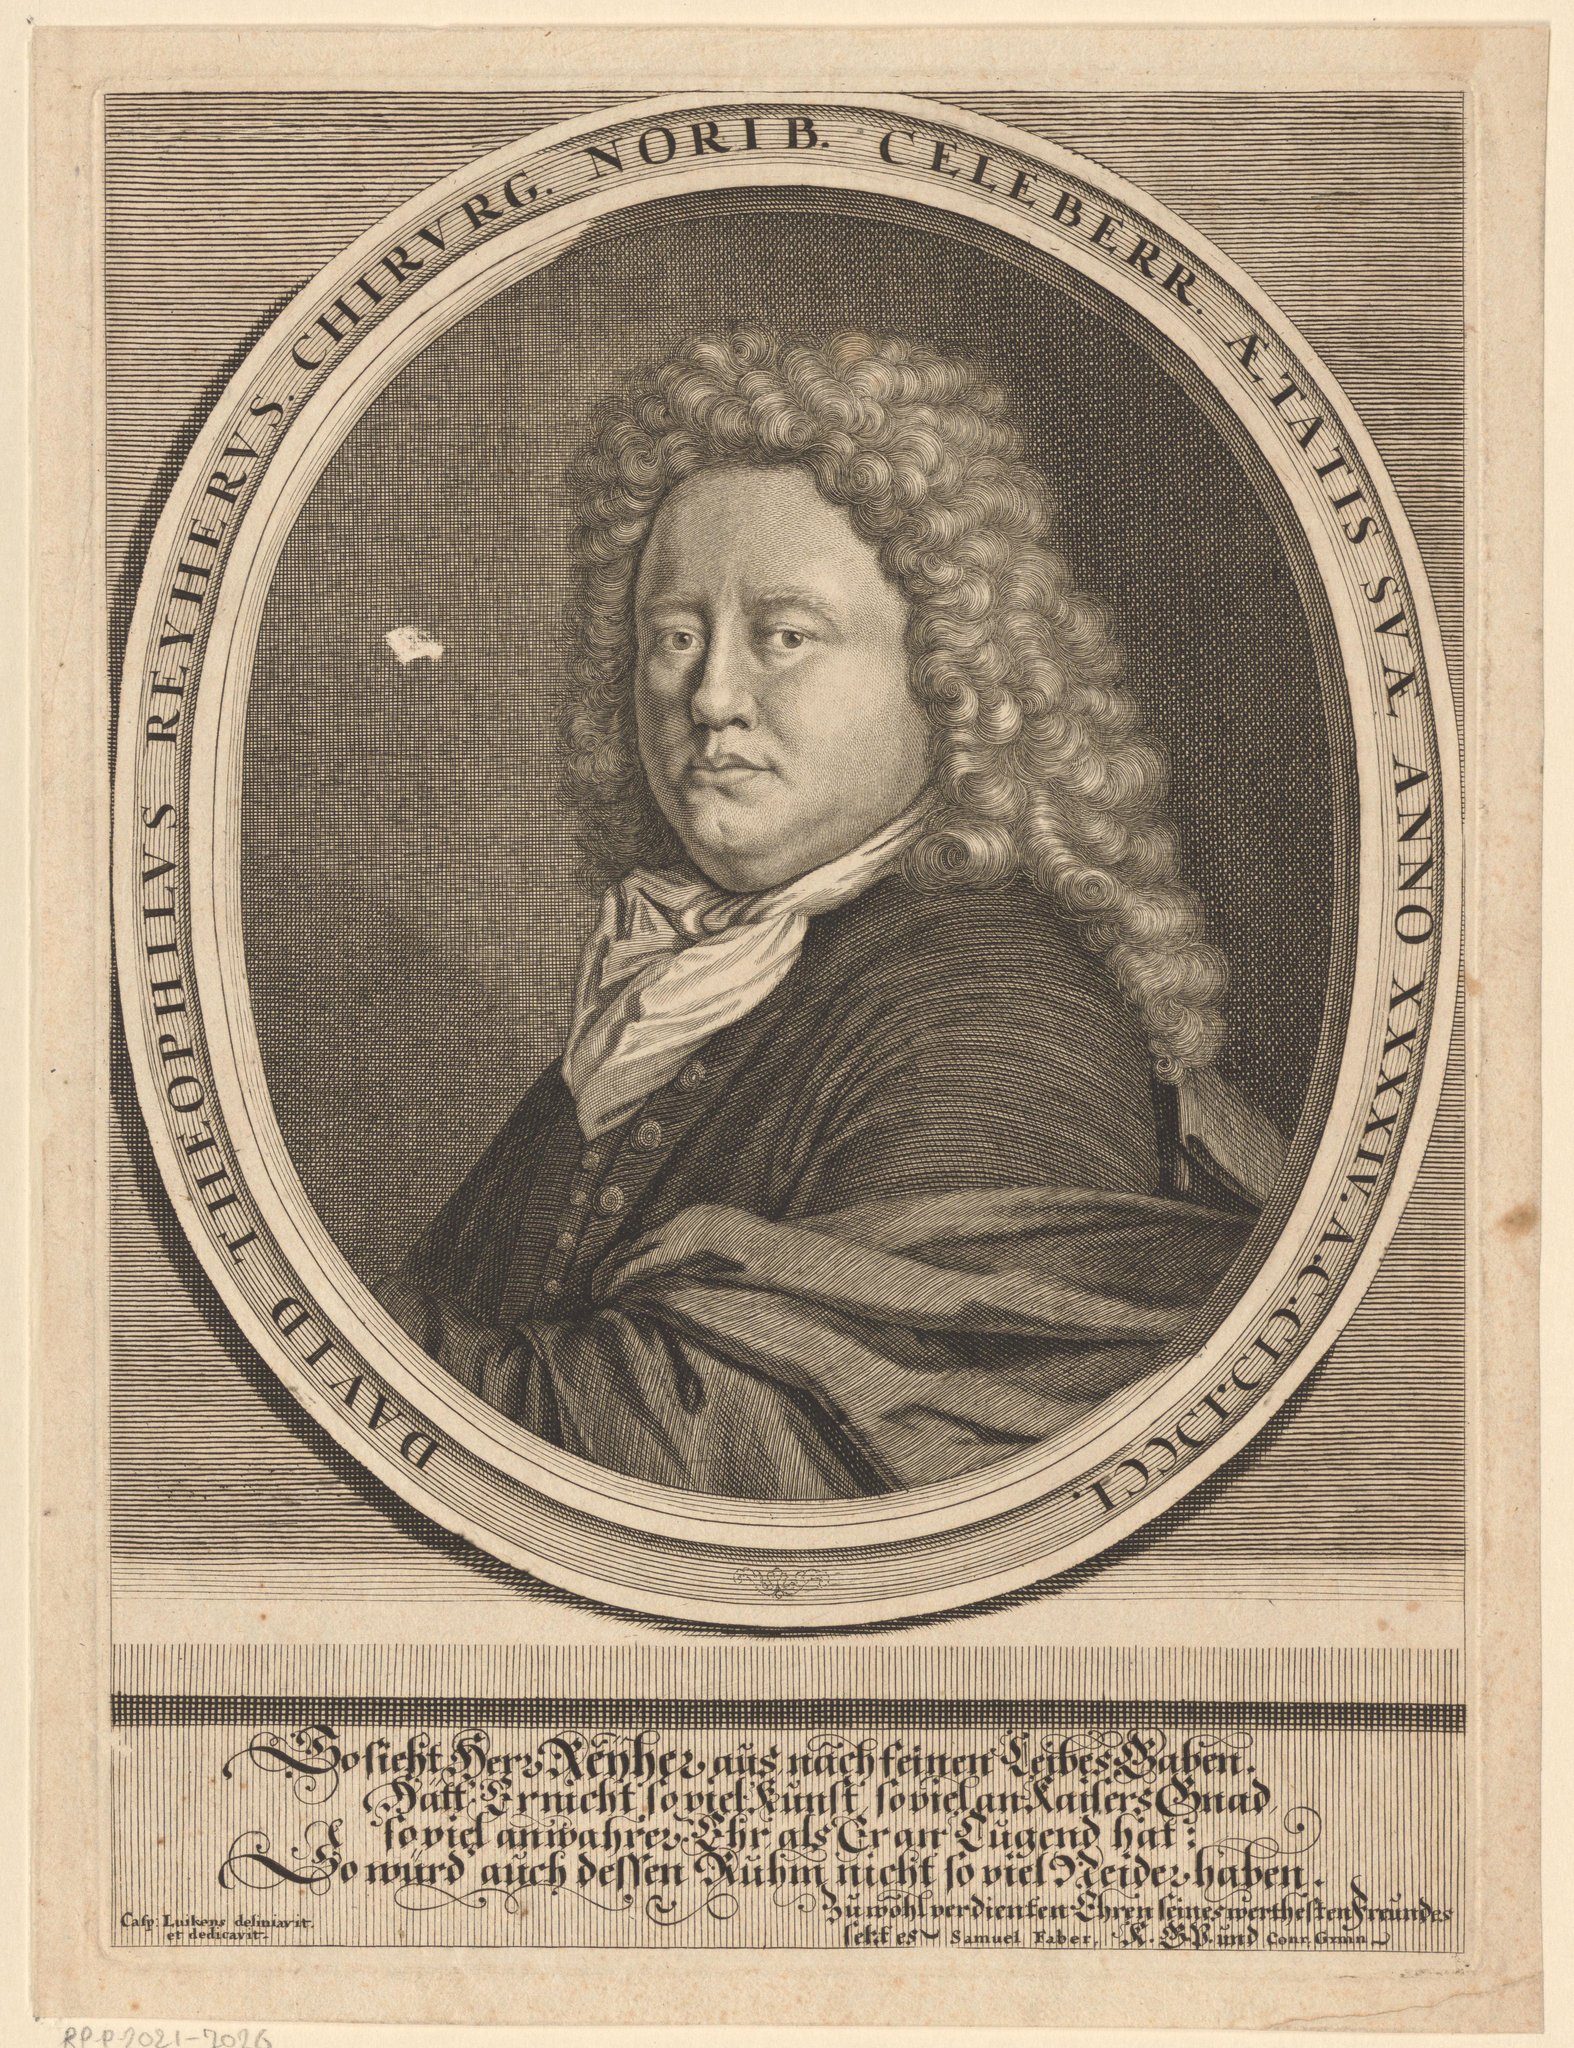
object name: print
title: Portret van David Reyher op 44-jarige leeftijd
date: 1701-1708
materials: paper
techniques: engraving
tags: historical persons